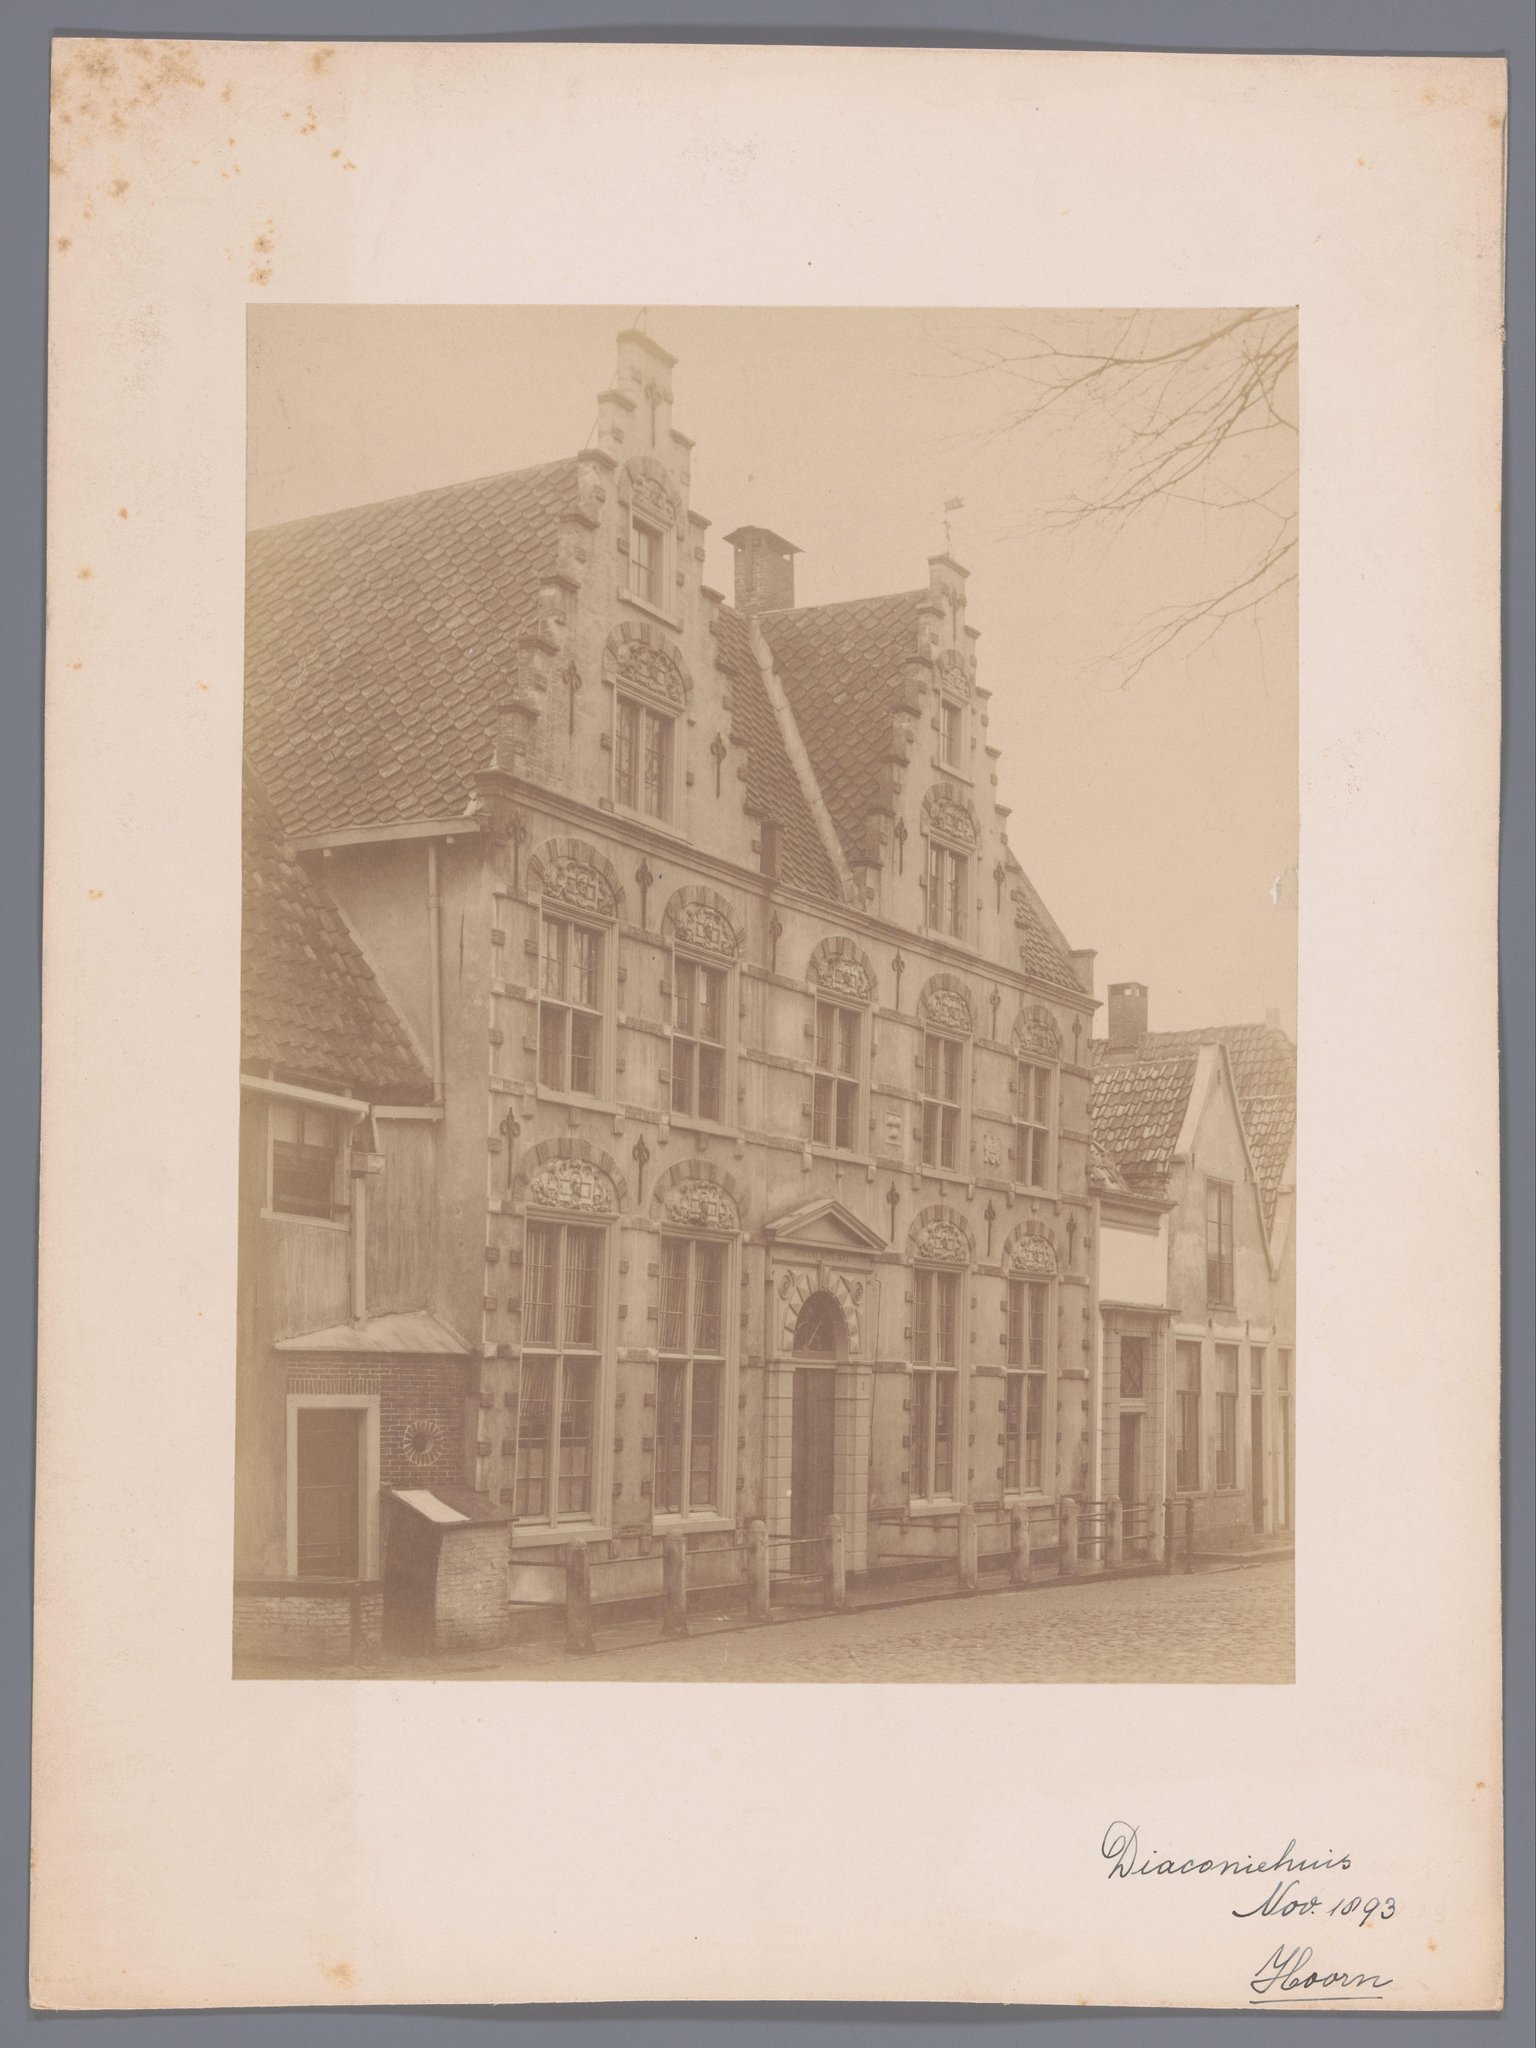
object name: photograph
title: Gezicht op het Diaconiehuis op Achterom 3 te Hoorn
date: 1893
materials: cardboard, photographic support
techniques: albumen print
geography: achterom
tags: façade (of house or building), civic architecture; edifices; dwellings, hoorn (north holland)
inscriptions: annotation: ‘Hoorn (N.H.)/ Diaconiehuis/ Nov. 1893’, annotation: ‘Diaconiehuis/ Nov. 1893/ Hoorn’